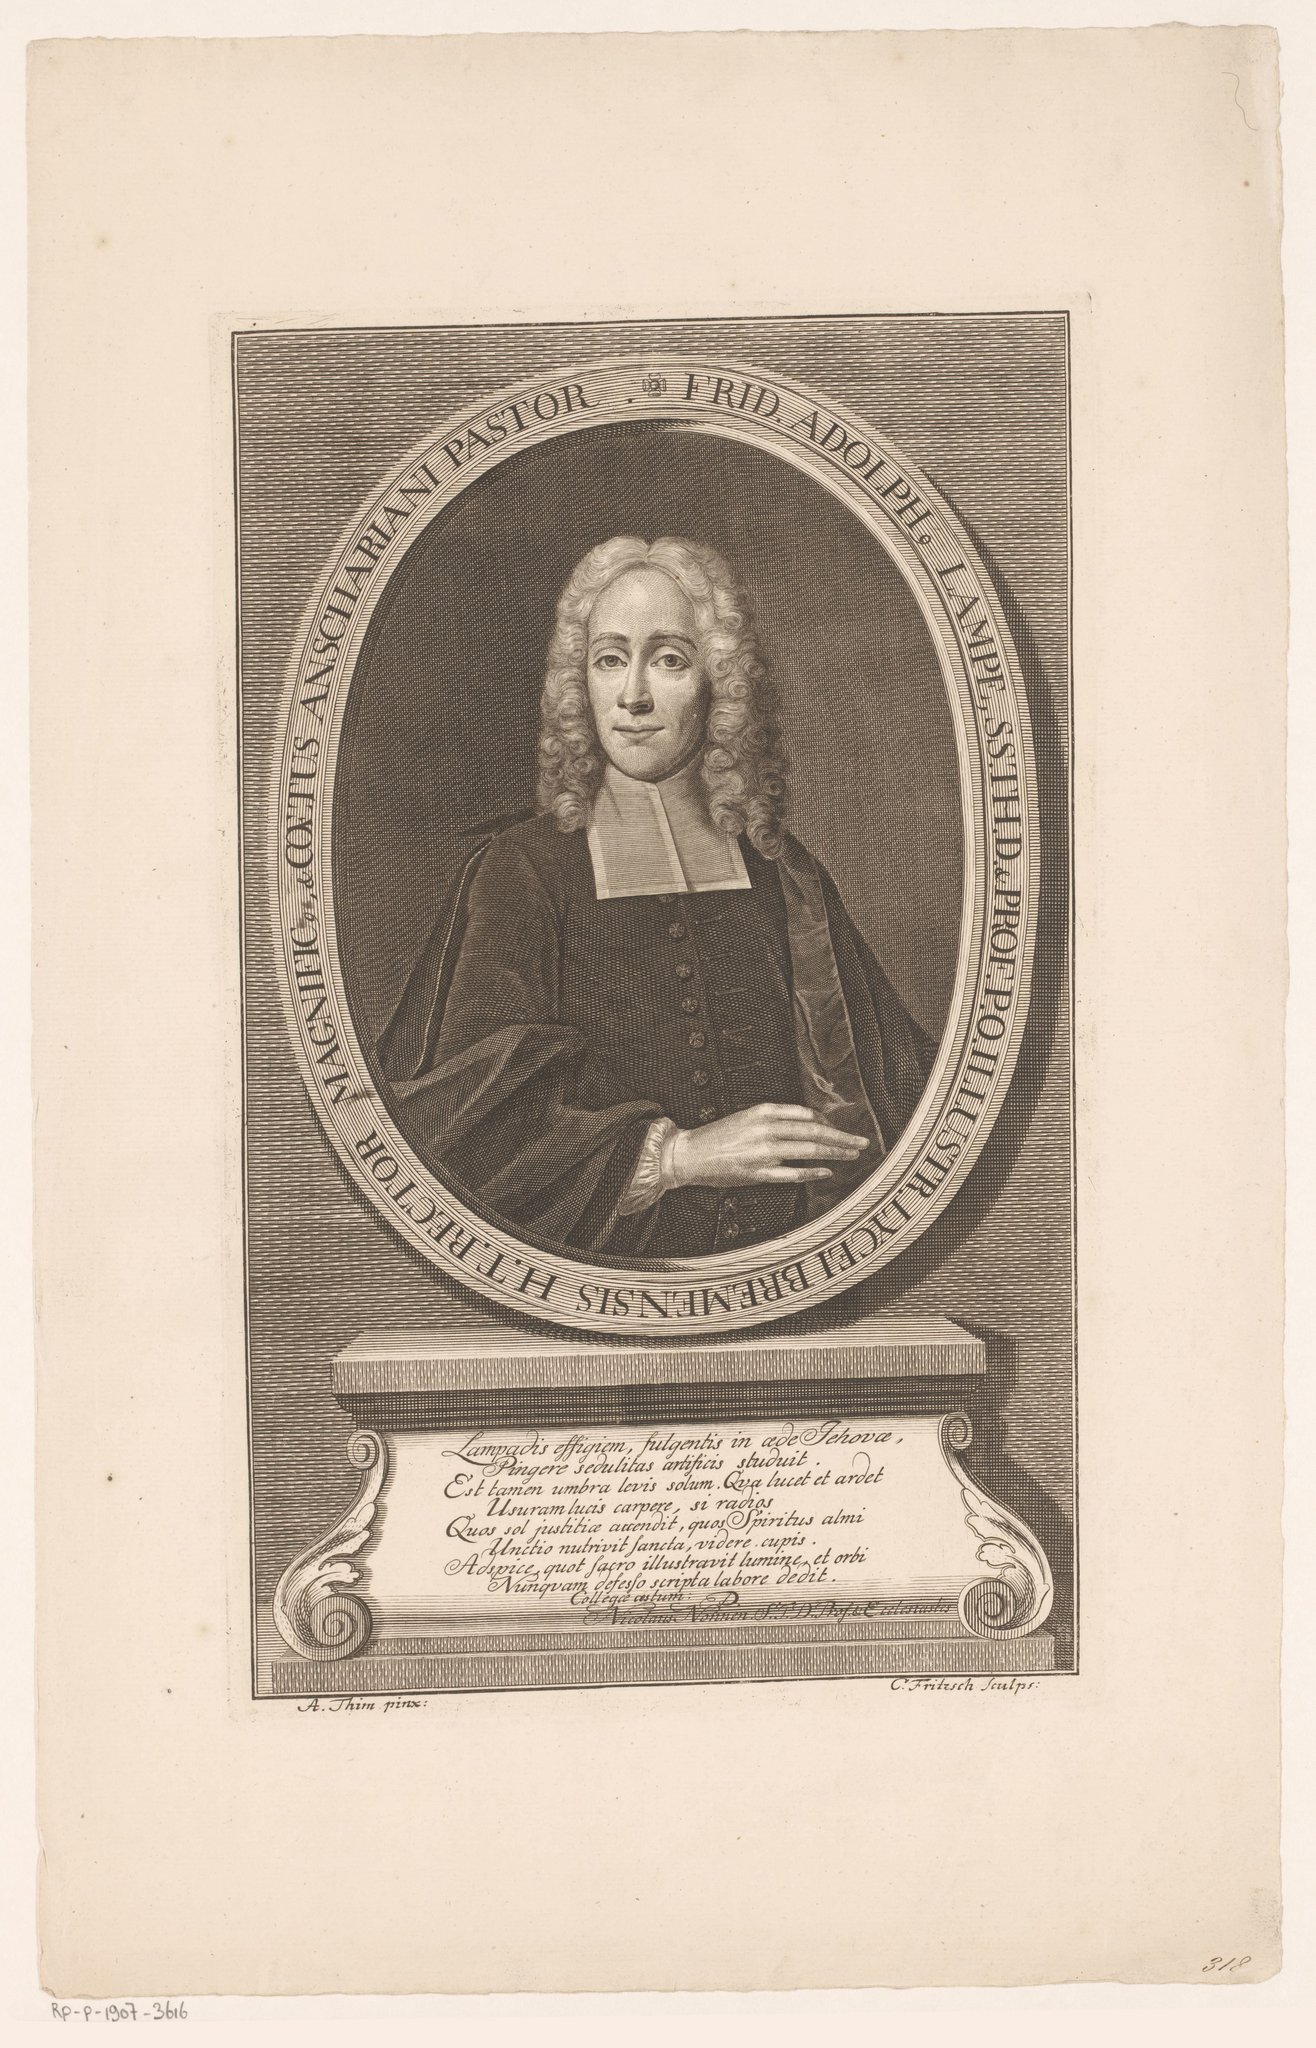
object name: print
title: Portret van Friedrich Adolph Lampe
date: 1705-1729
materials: paper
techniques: engraving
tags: ornament ~ medallion, historical persons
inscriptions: collector's mark: Lugt 2228